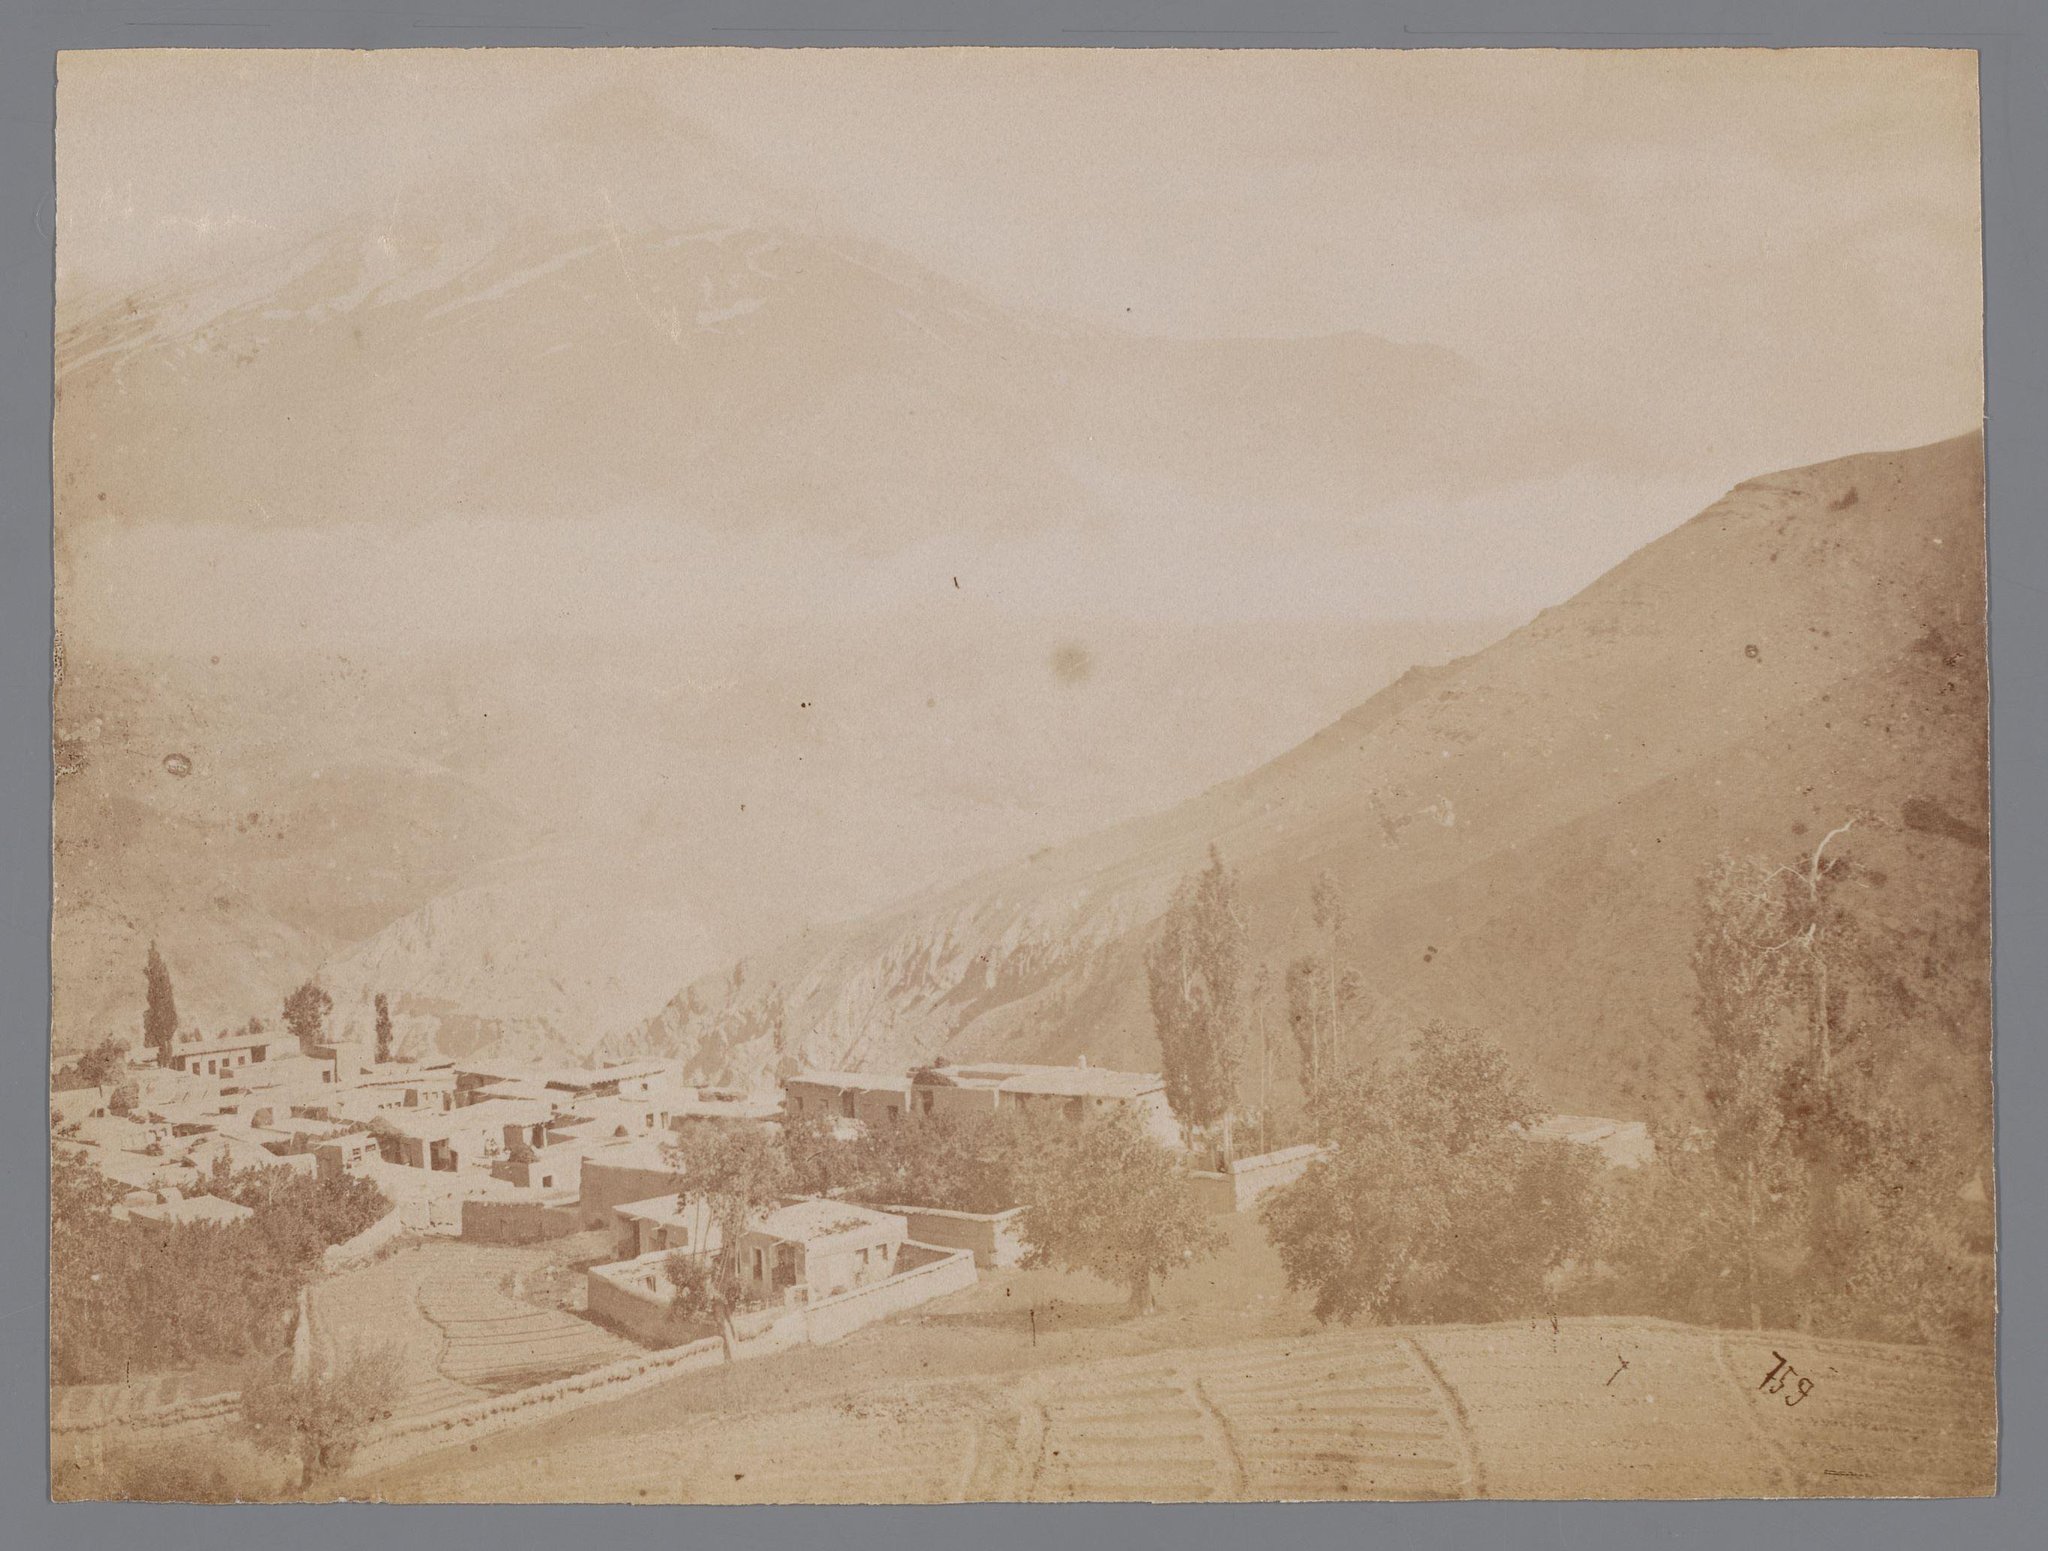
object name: photograph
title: Gezicht op een stad, Iran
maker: antoine sevruguin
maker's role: fotograaf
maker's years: 1840-1933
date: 1885-1910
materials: paper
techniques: albumen print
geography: iran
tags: iran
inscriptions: number: ‘759’, inscription: ‘Demaneneb [?]’, number: ‘4.’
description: Gezicht op een stad omringd door (besneeuwde) bergen, Iran.